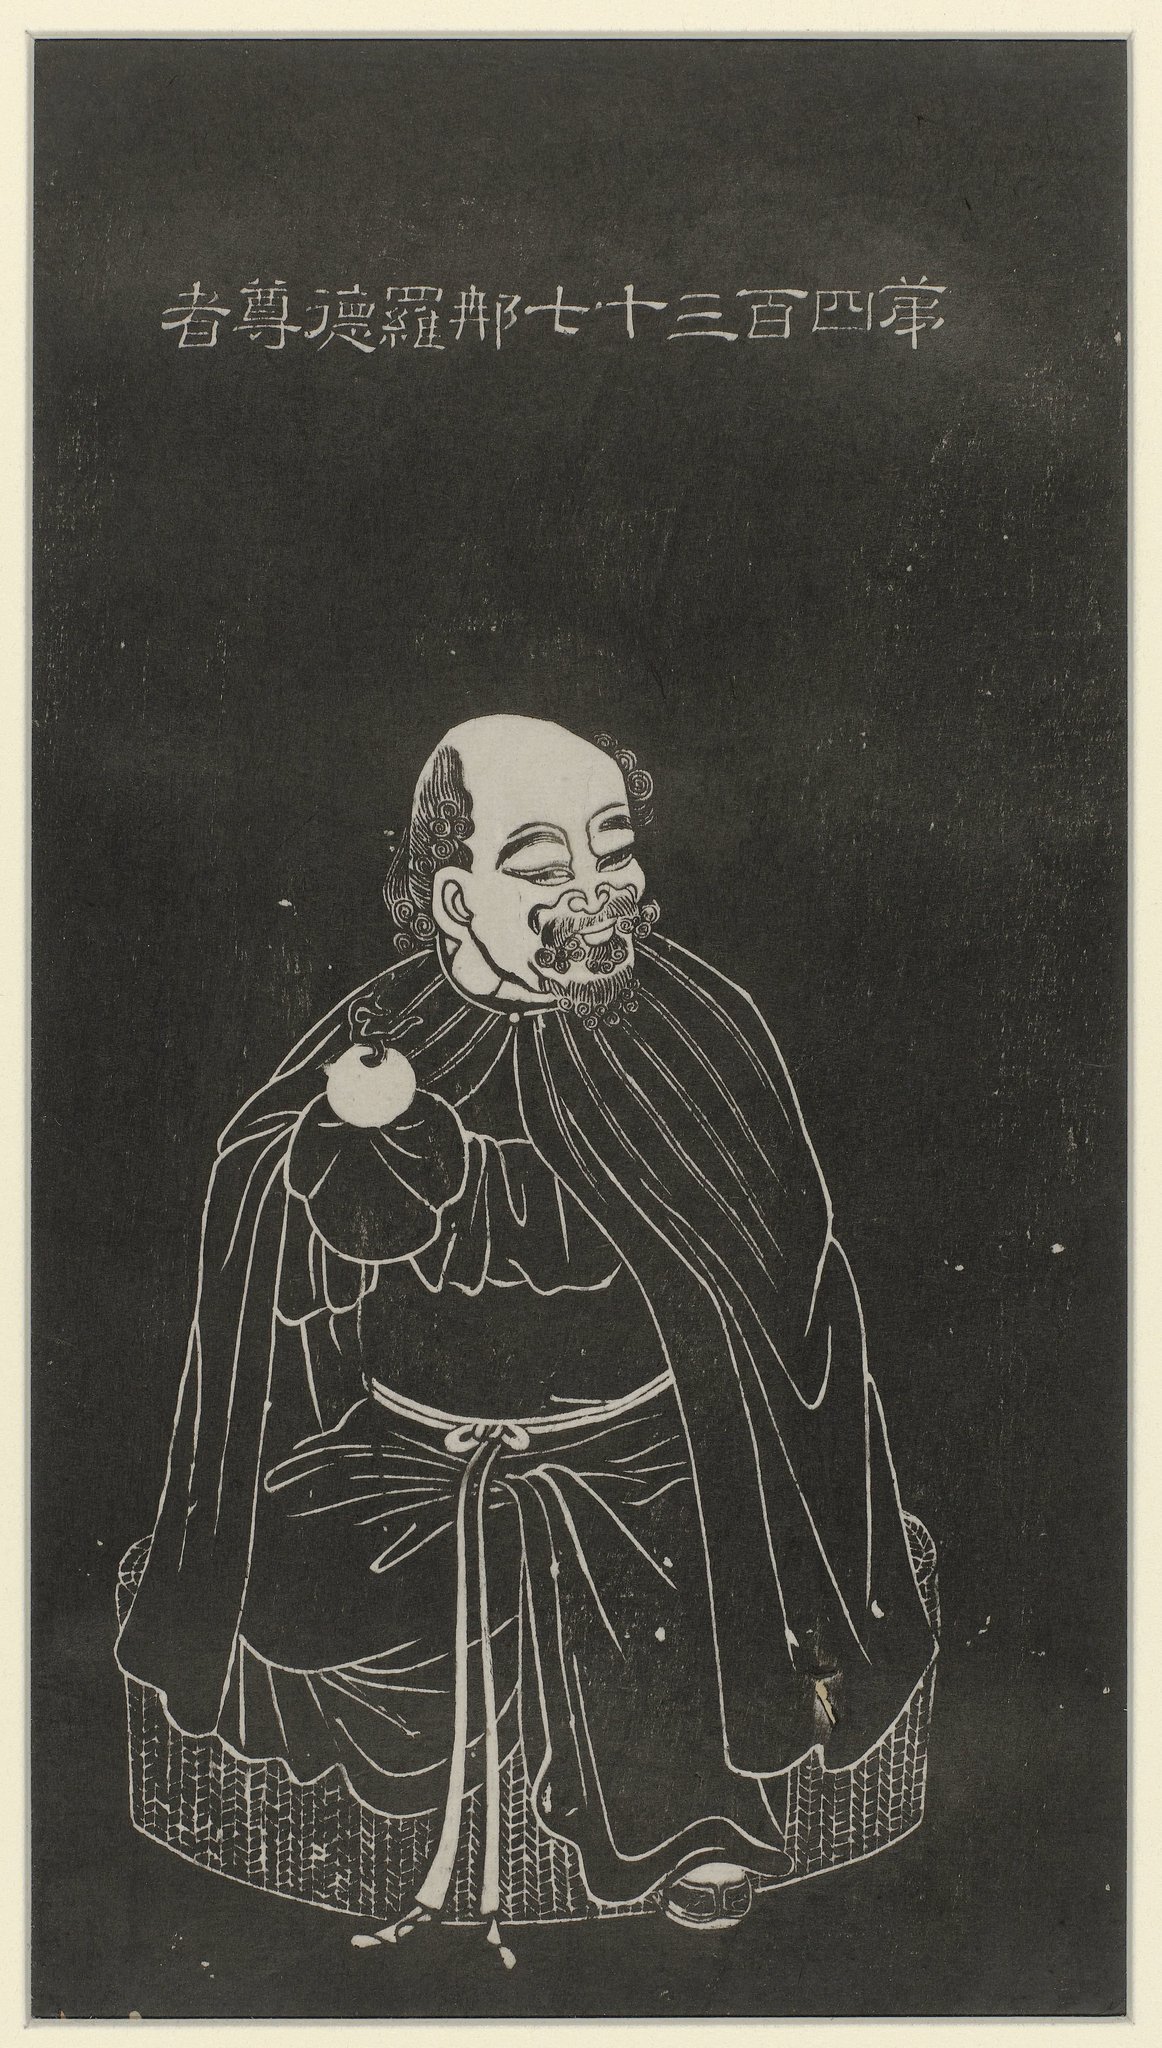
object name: wrijfprent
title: Lohan uit een serie v. 500; nr 437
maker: Anonymous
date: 1600-1699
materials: paper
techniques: rubbing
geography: china